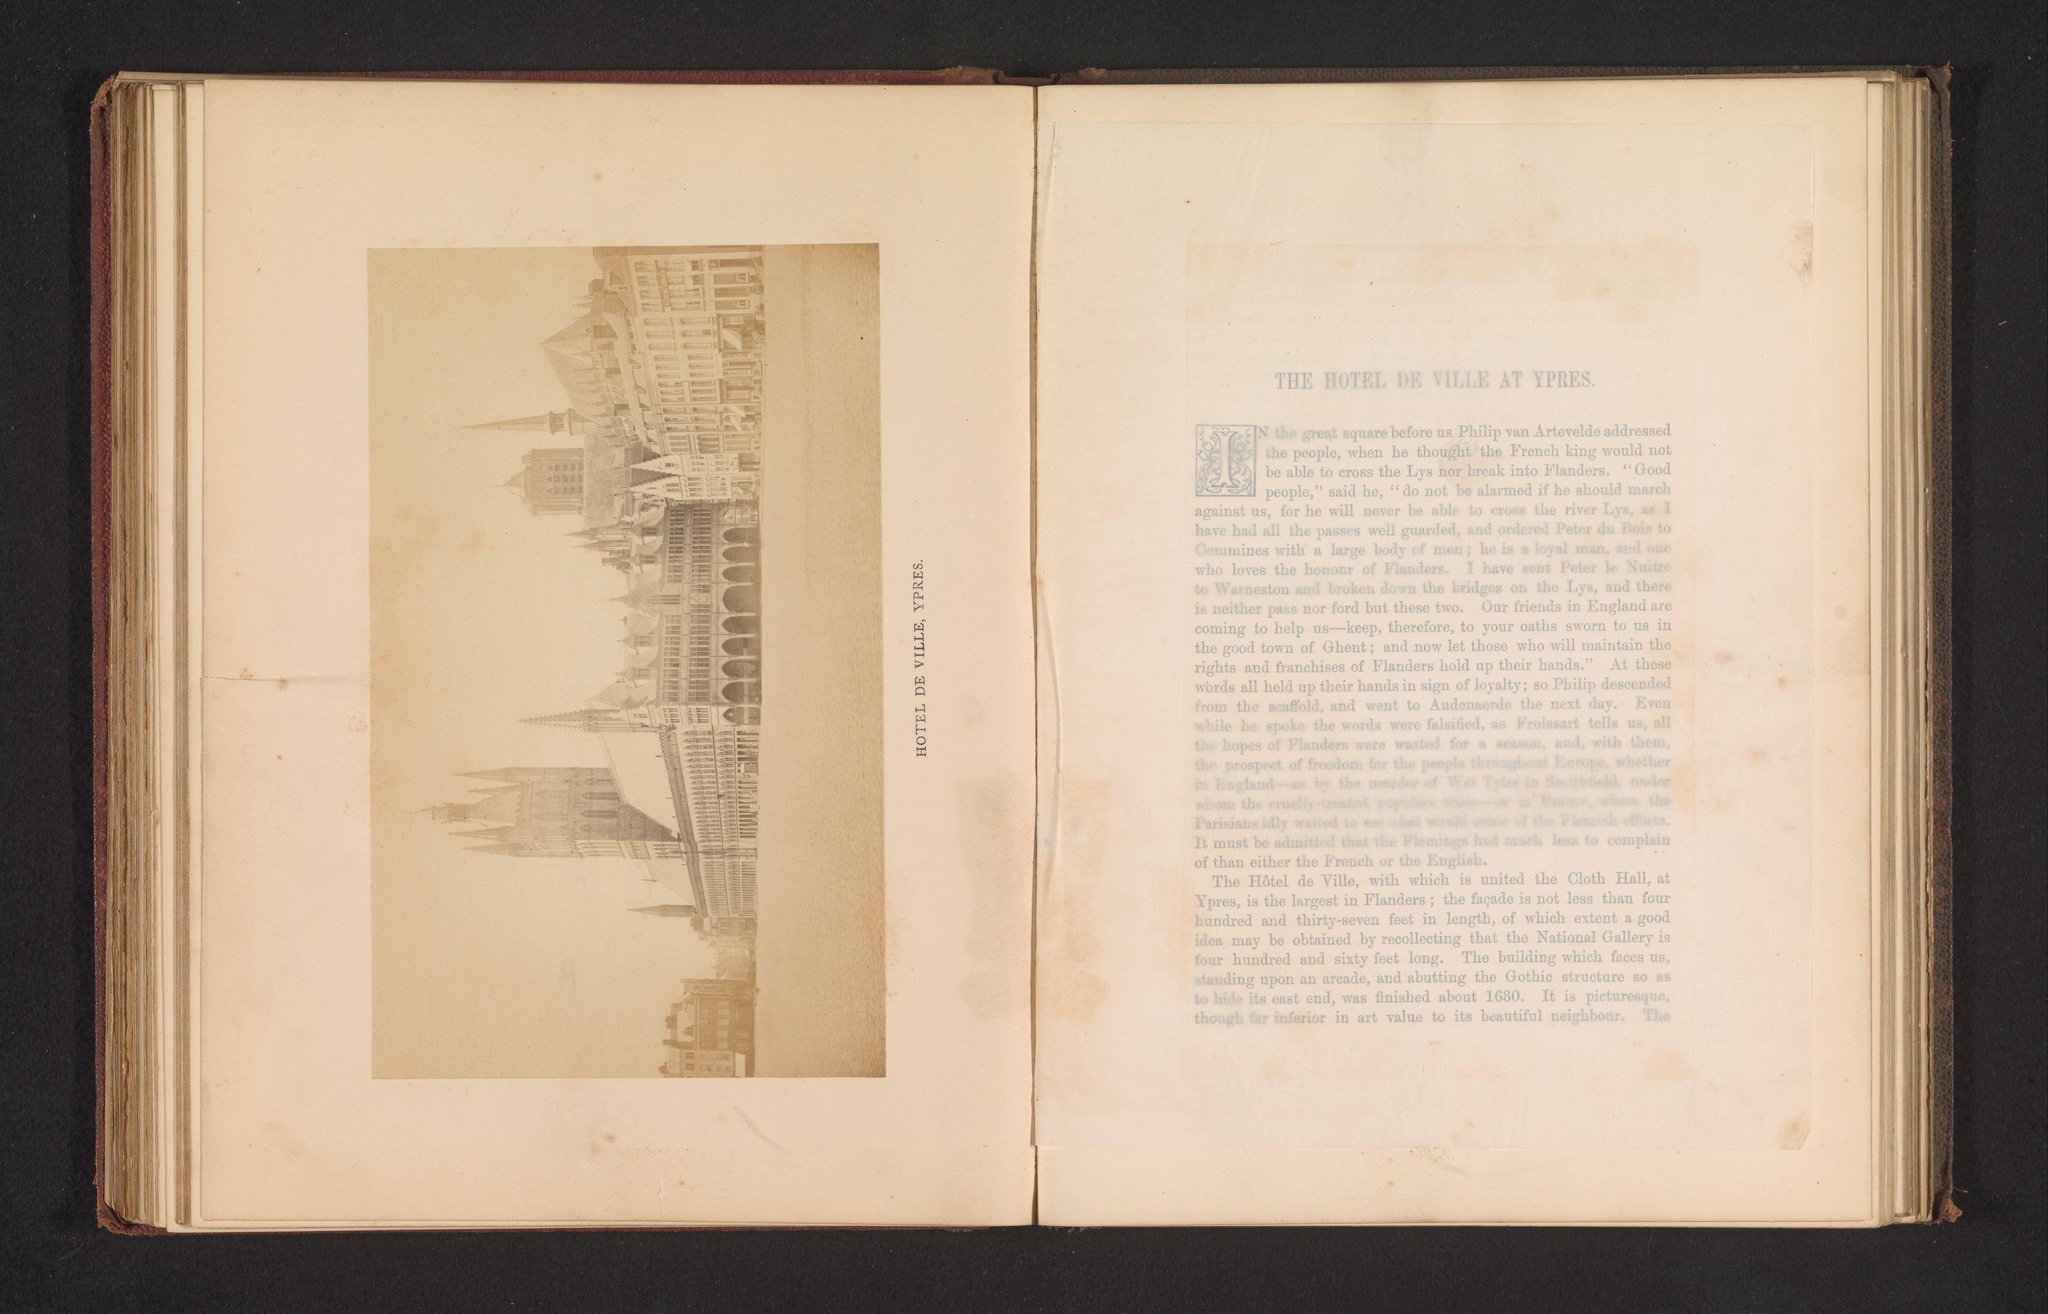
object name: photograph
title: Hotel de ville, Ypres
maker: Anonymous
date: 1856-1866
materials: photographic support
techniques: albumen print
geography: ieper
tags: square, place, circus, etc., façade (of house or building)